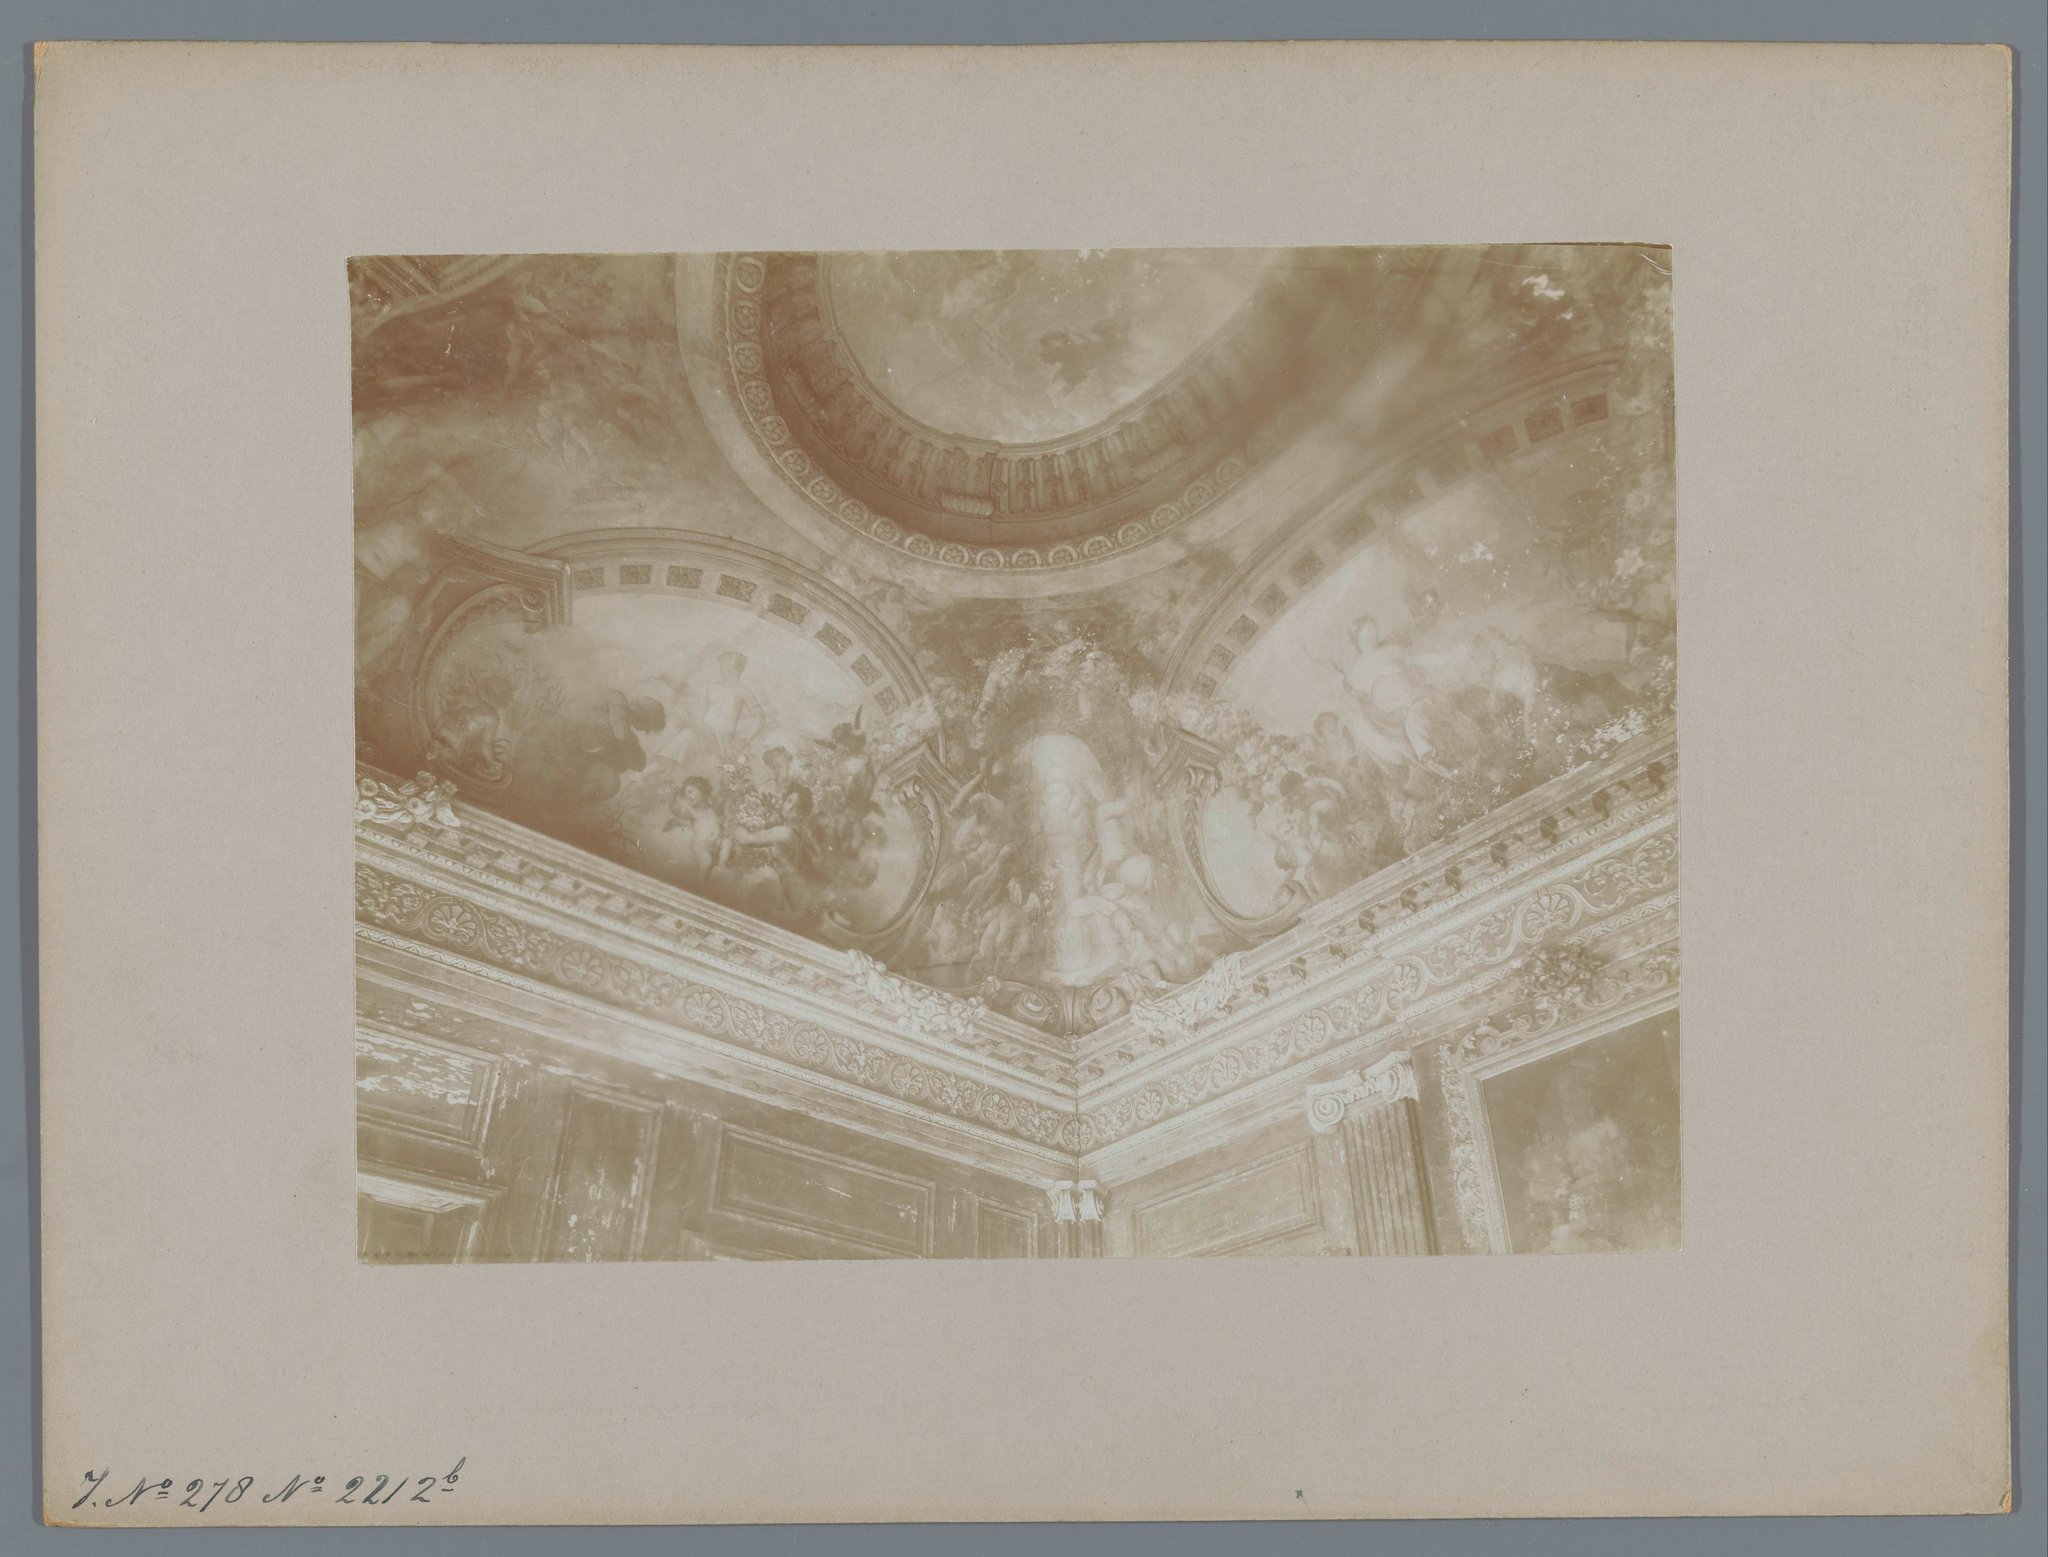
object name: photograph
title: Deel van een beschilderd koepelplafond in een huis aan het Noordeinde te Den Haag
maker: Anonymous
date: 1901-1912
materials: cardboard, photographic support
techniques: collodion silver print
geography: noordeinde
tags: (decorated) ceiling, interior ~ representation of a building, cupids: 'amores', 'amoretti', 'putti'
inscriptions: inscription: ‘Een der hoeken van het plafond . Koepel voorm. huis Fagel Noordeinde den Haag Jan. 1912.’, inscription: ‘neg. no 15064 foto no 7290’, annotation